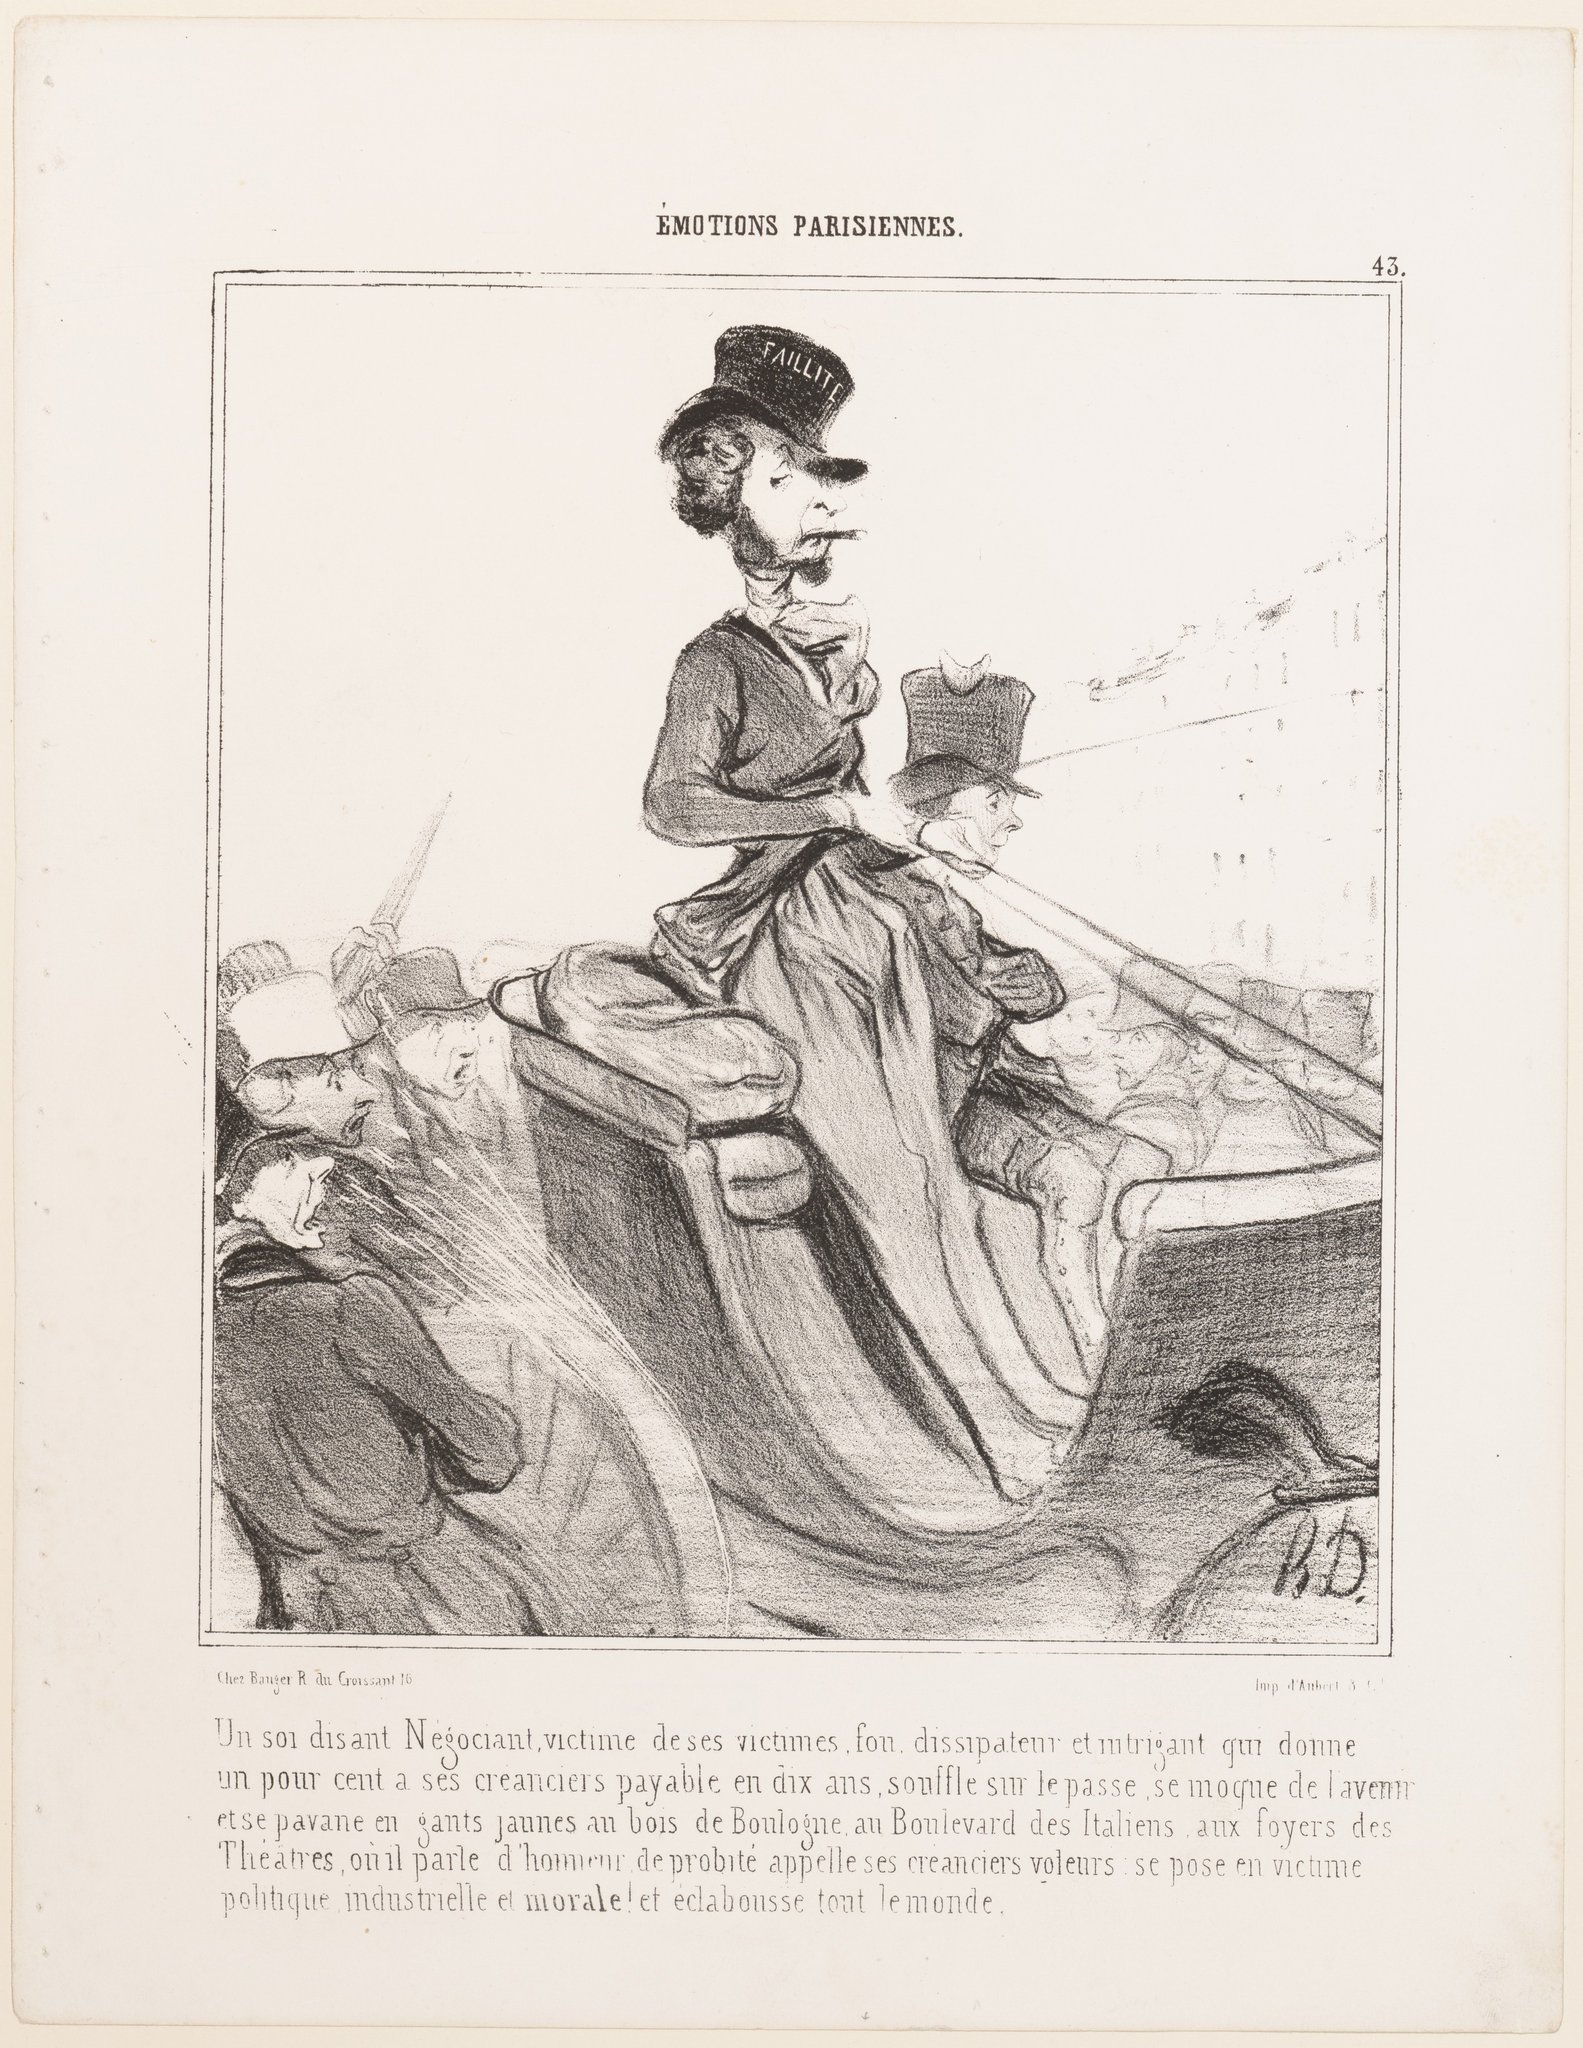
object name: print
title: Un soi disant Négociant... (A so-called Merchant...), from Émotions Parisiennes, published in "Le Charivari"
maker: honoré daumier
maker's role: artist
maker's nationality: french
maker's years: 1808-1879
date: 1840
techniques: lithograph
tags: men,smoking